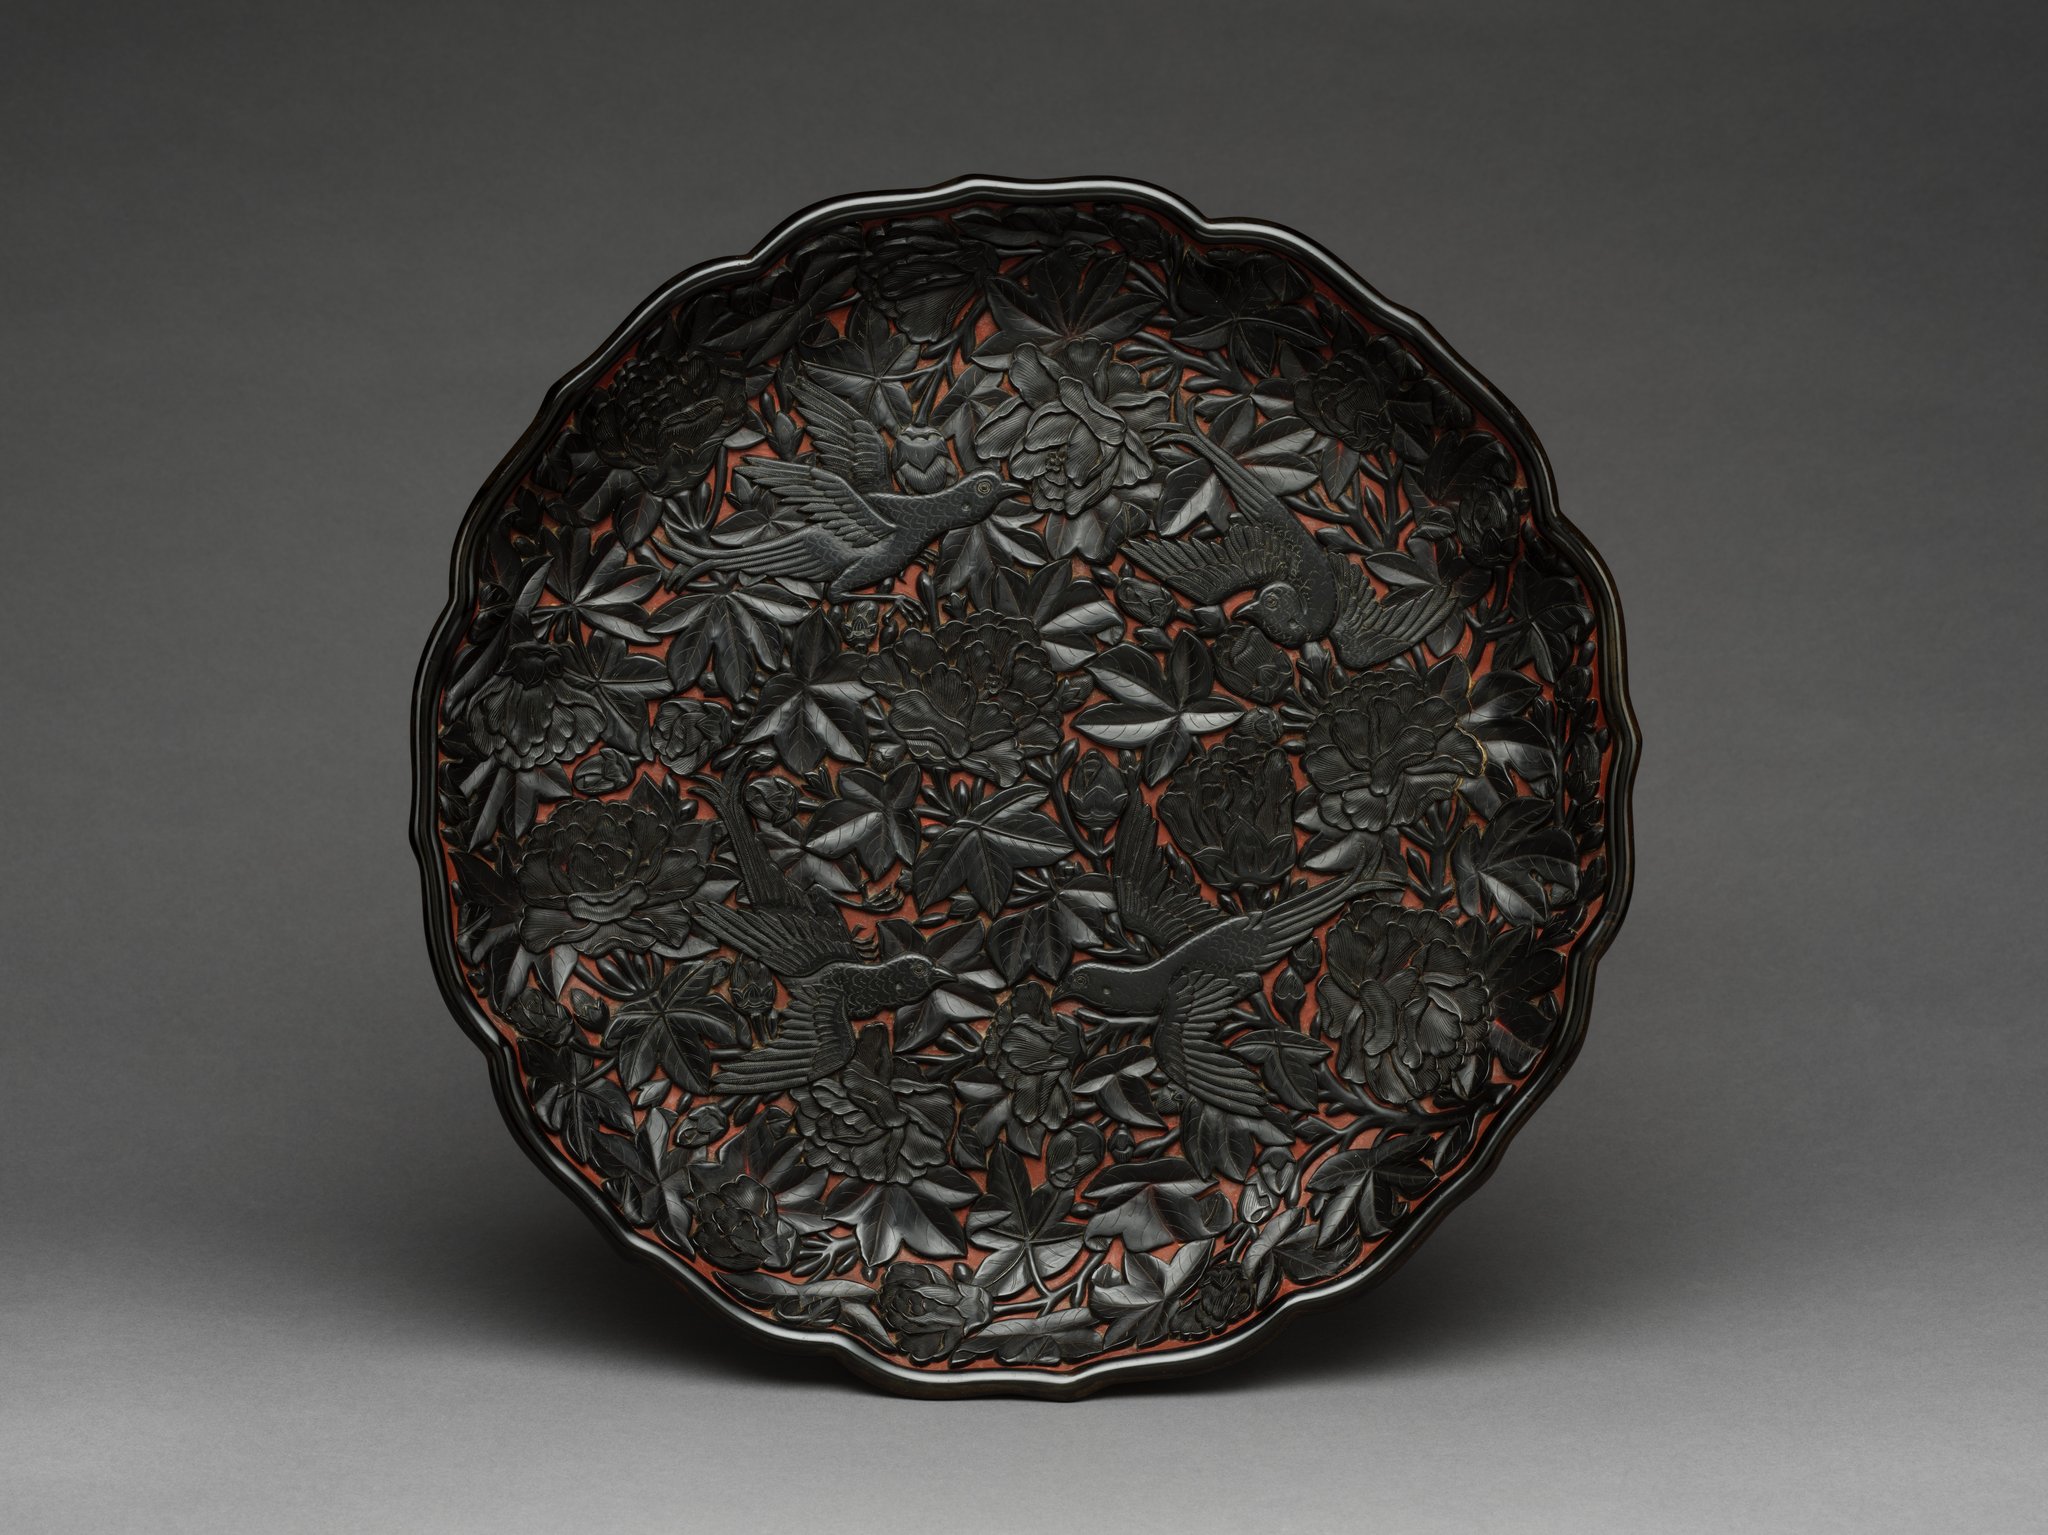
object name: dish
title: Foliated dish with four birds and flowers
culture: chinese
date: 1401-1500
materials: lacquer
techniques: carving